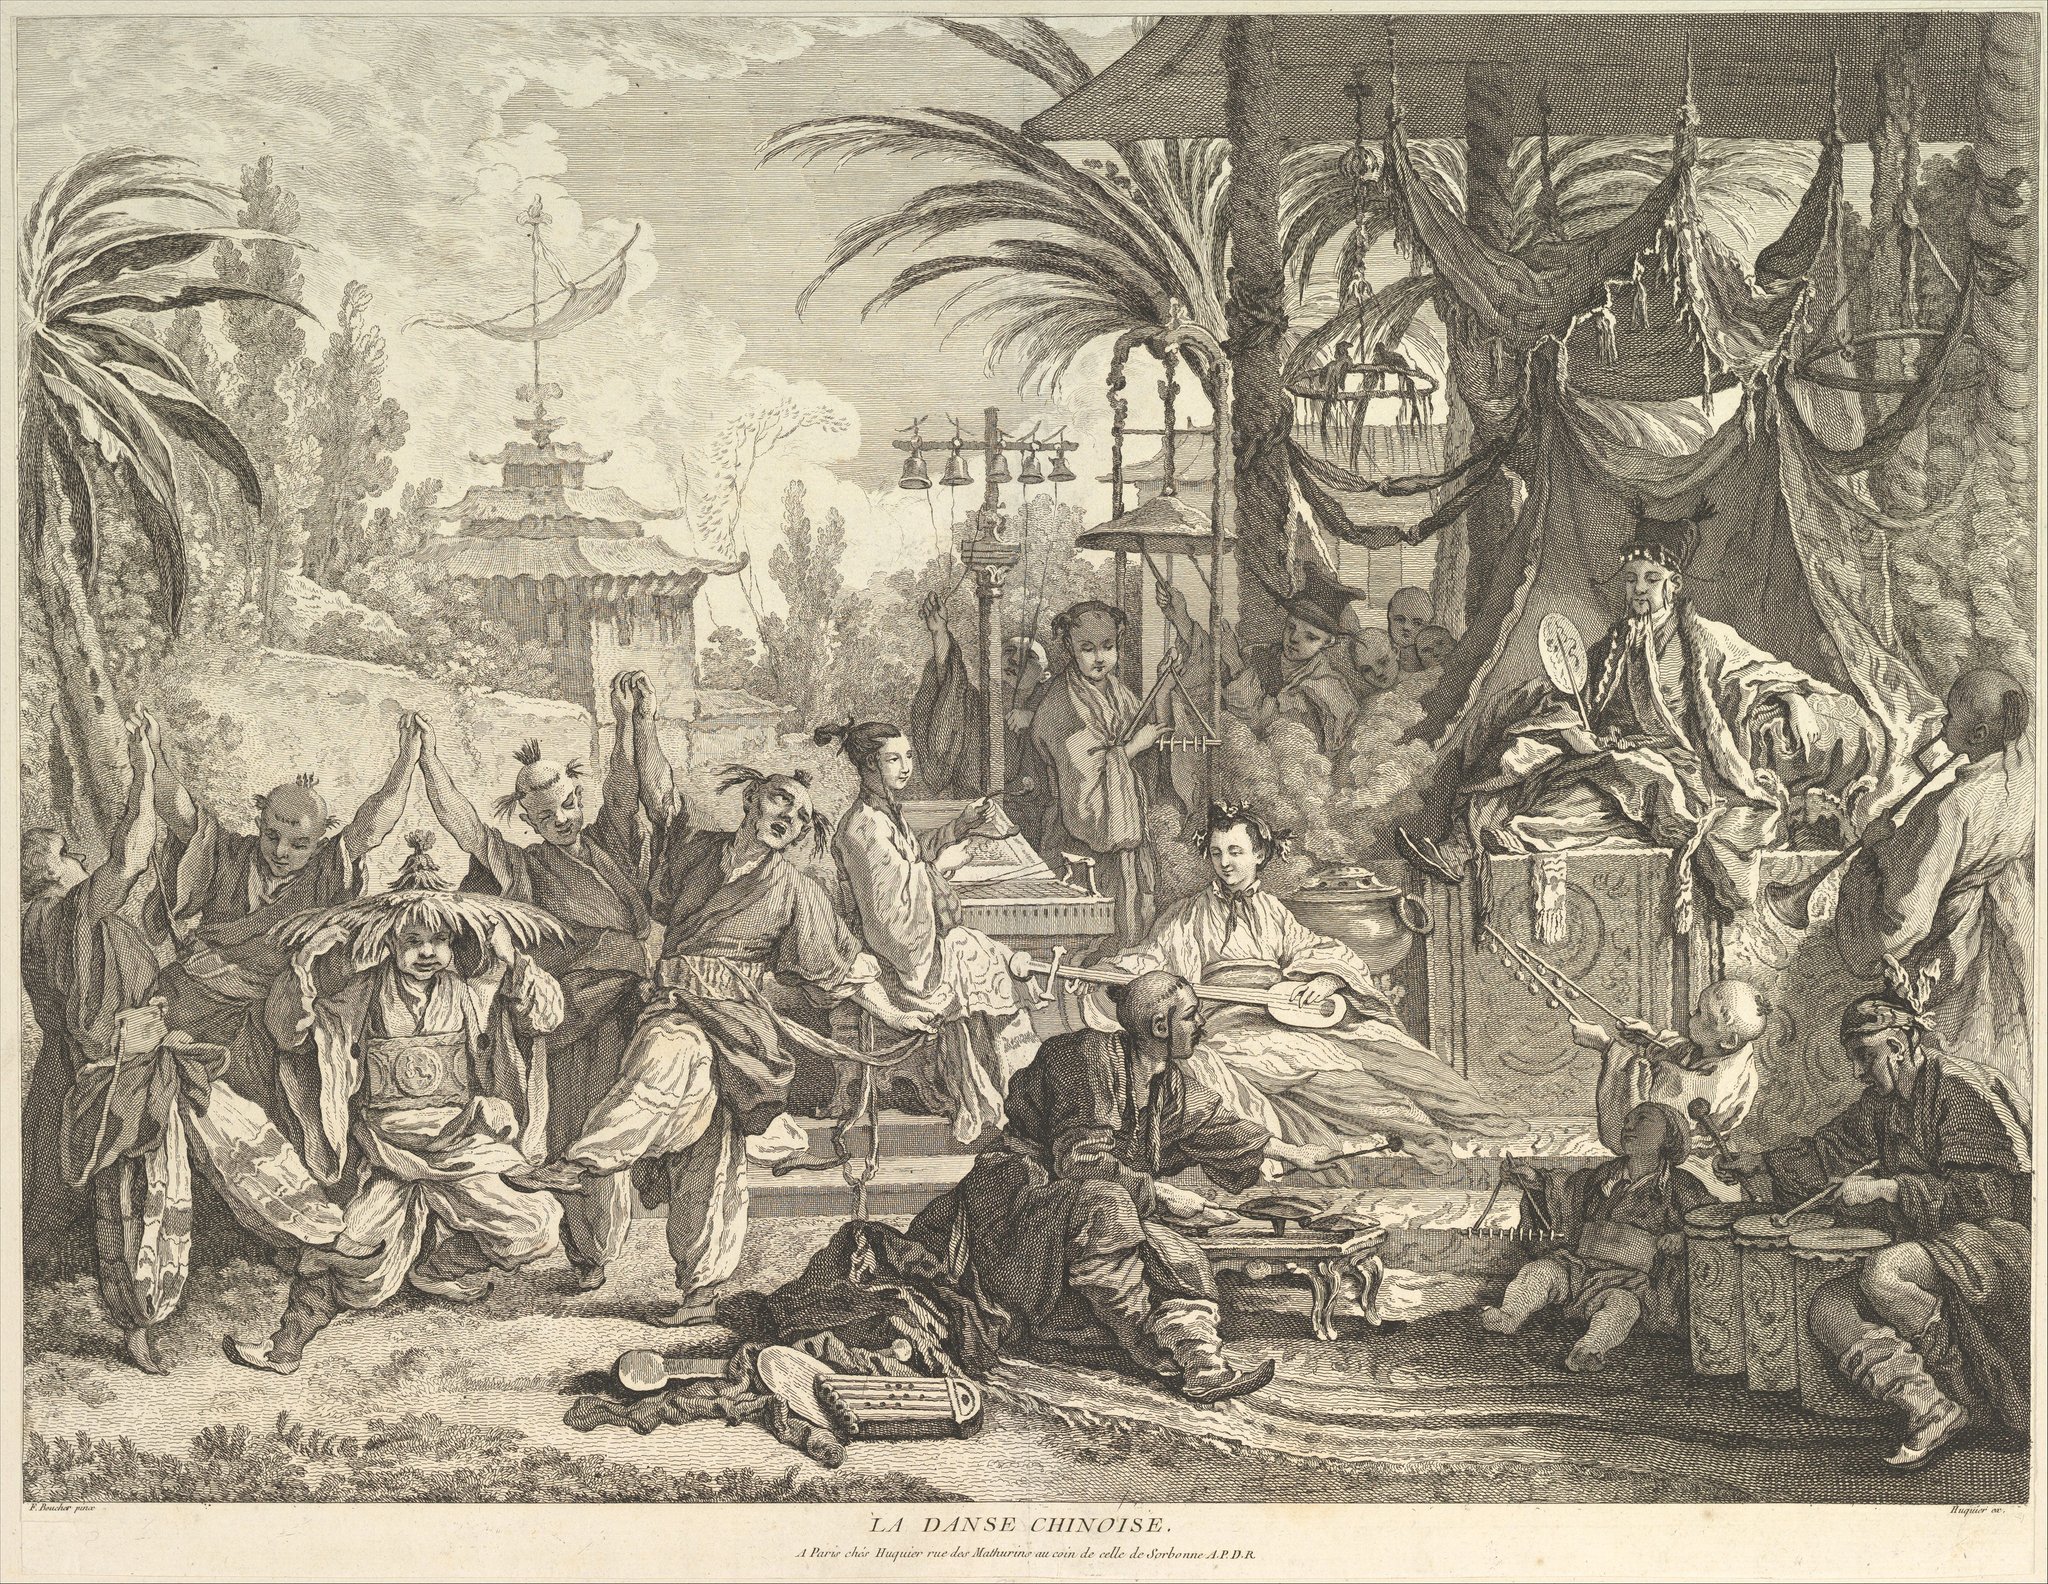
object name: collection ornament architecture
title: La Danse Chinoise (The Chinese Dance), from Chinoiseries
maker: jacques gabriel huquier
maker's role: artist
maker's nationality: french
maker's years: 1730-1805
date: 1743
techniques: engraving, etching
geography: france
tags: men,women,dancing,trees